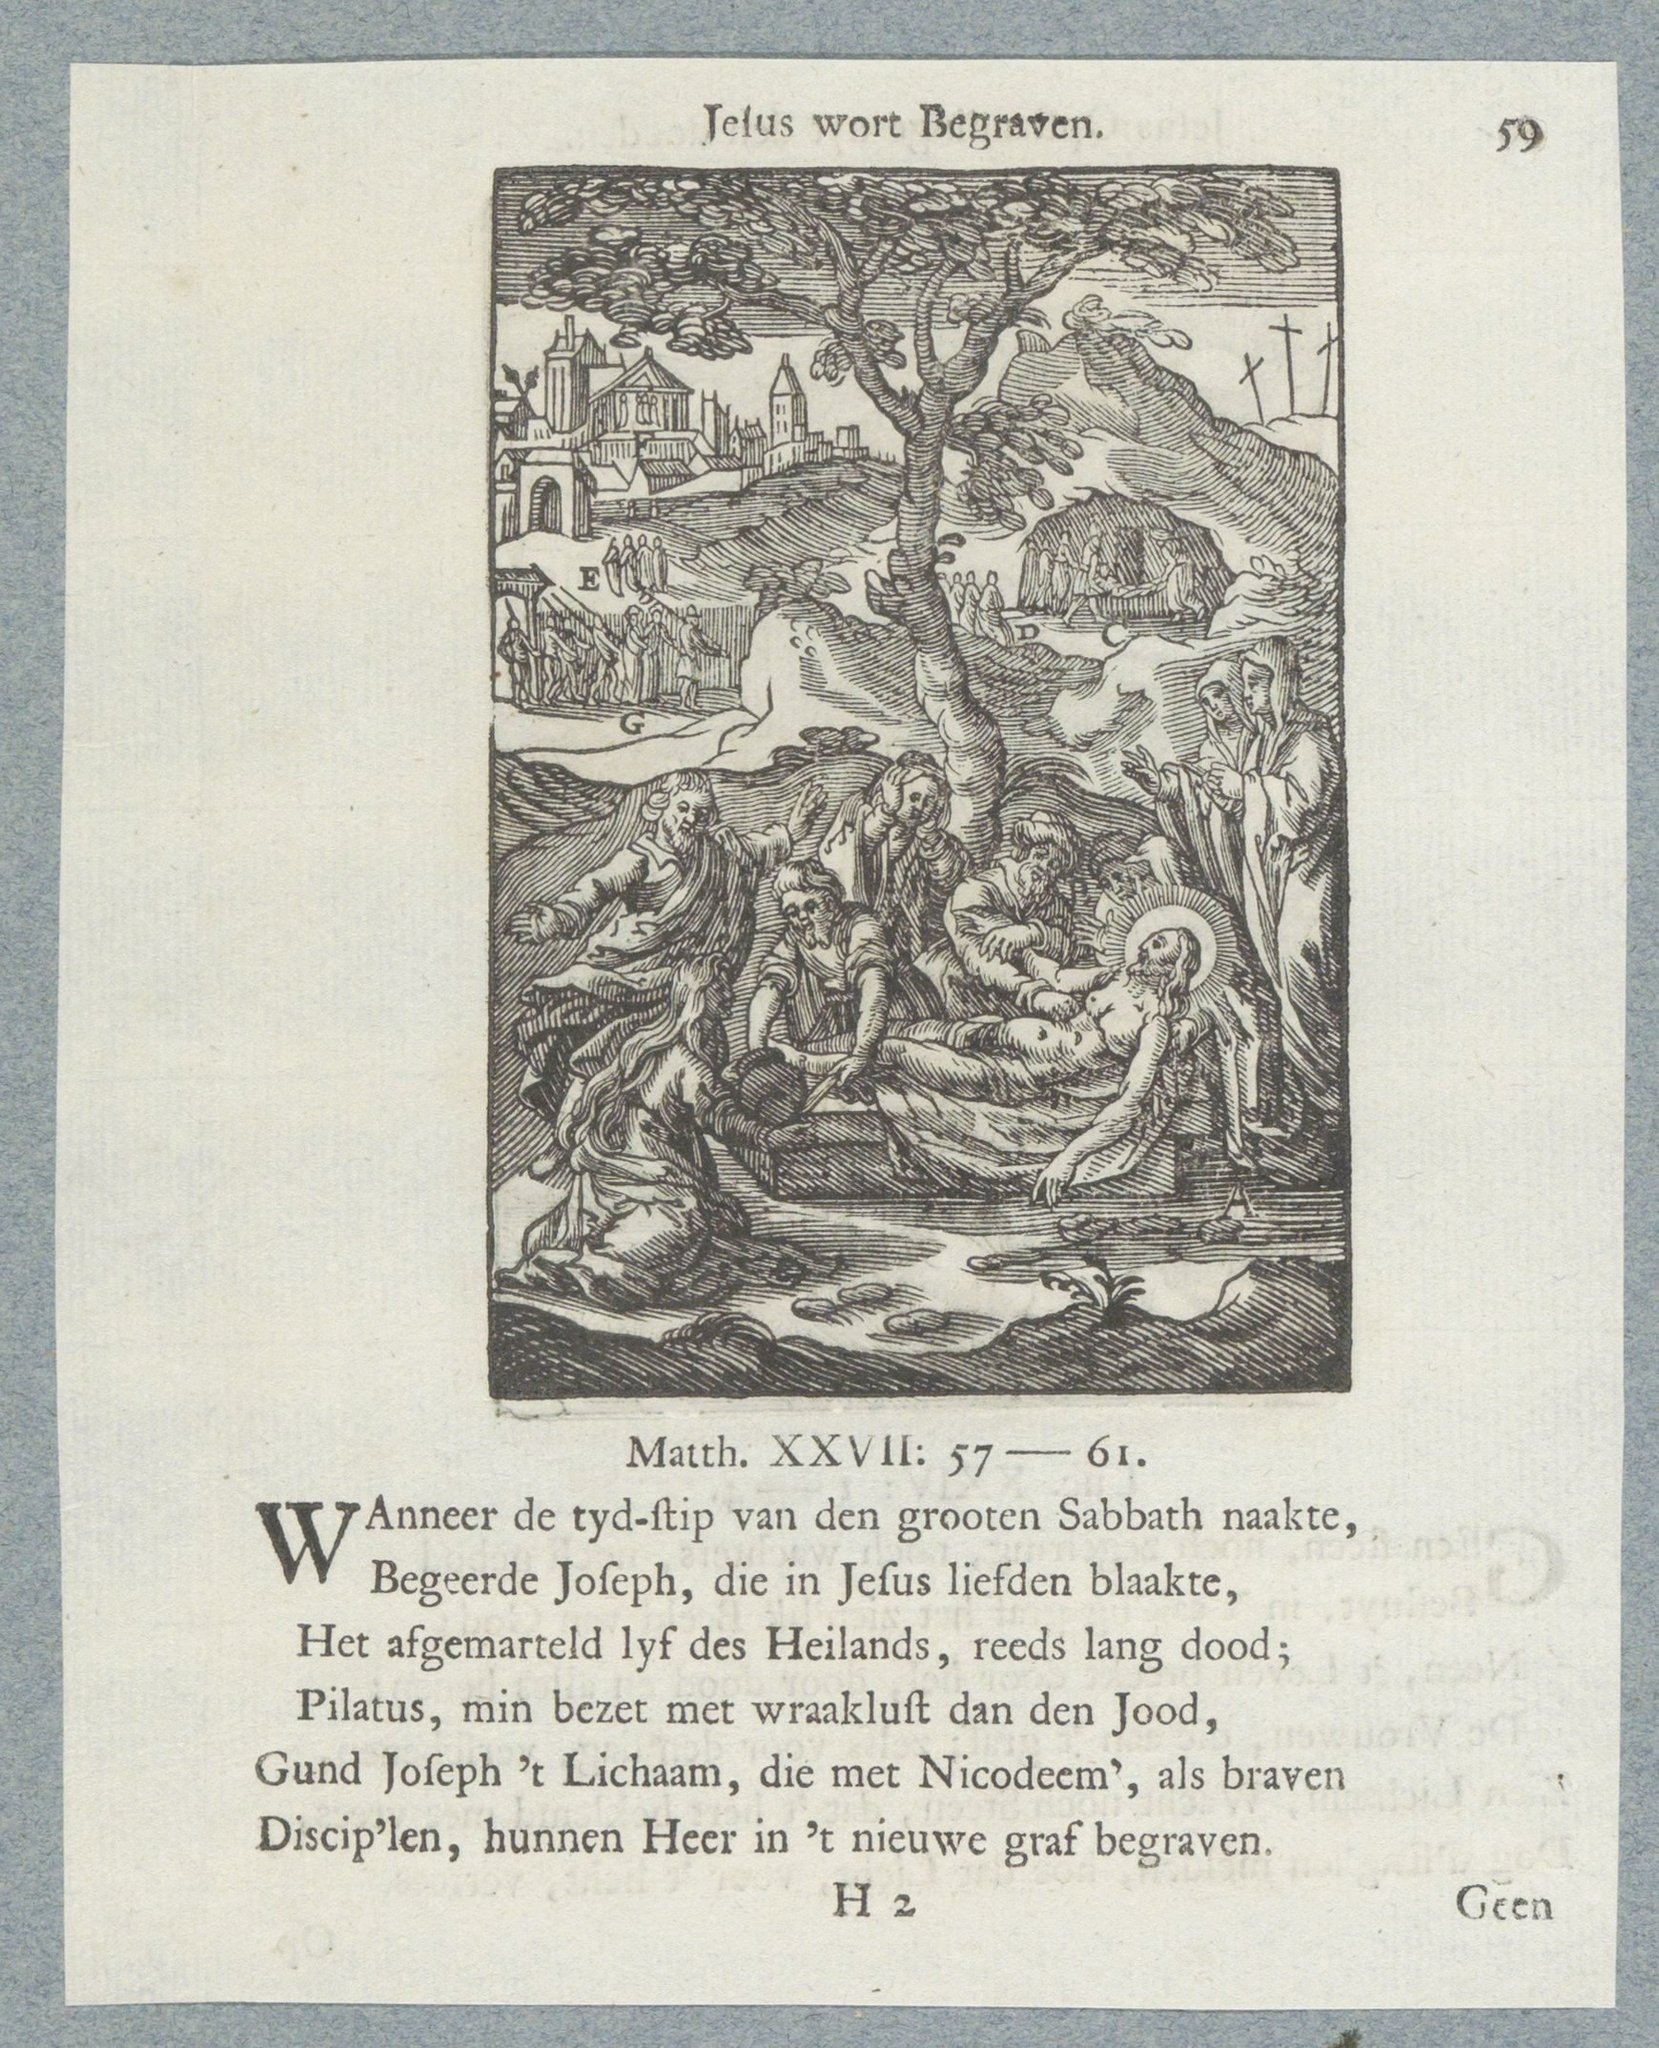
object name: book illustration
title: Jesus wort begraven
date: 1629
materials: paper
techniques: letterpress printing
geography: amsterdam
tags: christ's entombment (possibly by angels), christ's body is wrapped in a shroud and in bandages, christ lying on the stone of unction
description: Christus dode lichaam wordt gezalfd en in doeken gewikkeld. Verschillende vrouwen, onder wie Maria en Maria Magdalena, treuren bij zijn baar. Op de achtergrond rechts wordt Christus het rotsgraf ingedragen. Links komen de wachters aangelopen die het graf zullen gaan bewaken. Bij verschillende elementen uit de voorstelling staan letters. Boven de voorstelling een titel. Eronder zes versregels en een verwijzing naar Mattheüs 27: 57-61. De prent maakt deel uit van een album.